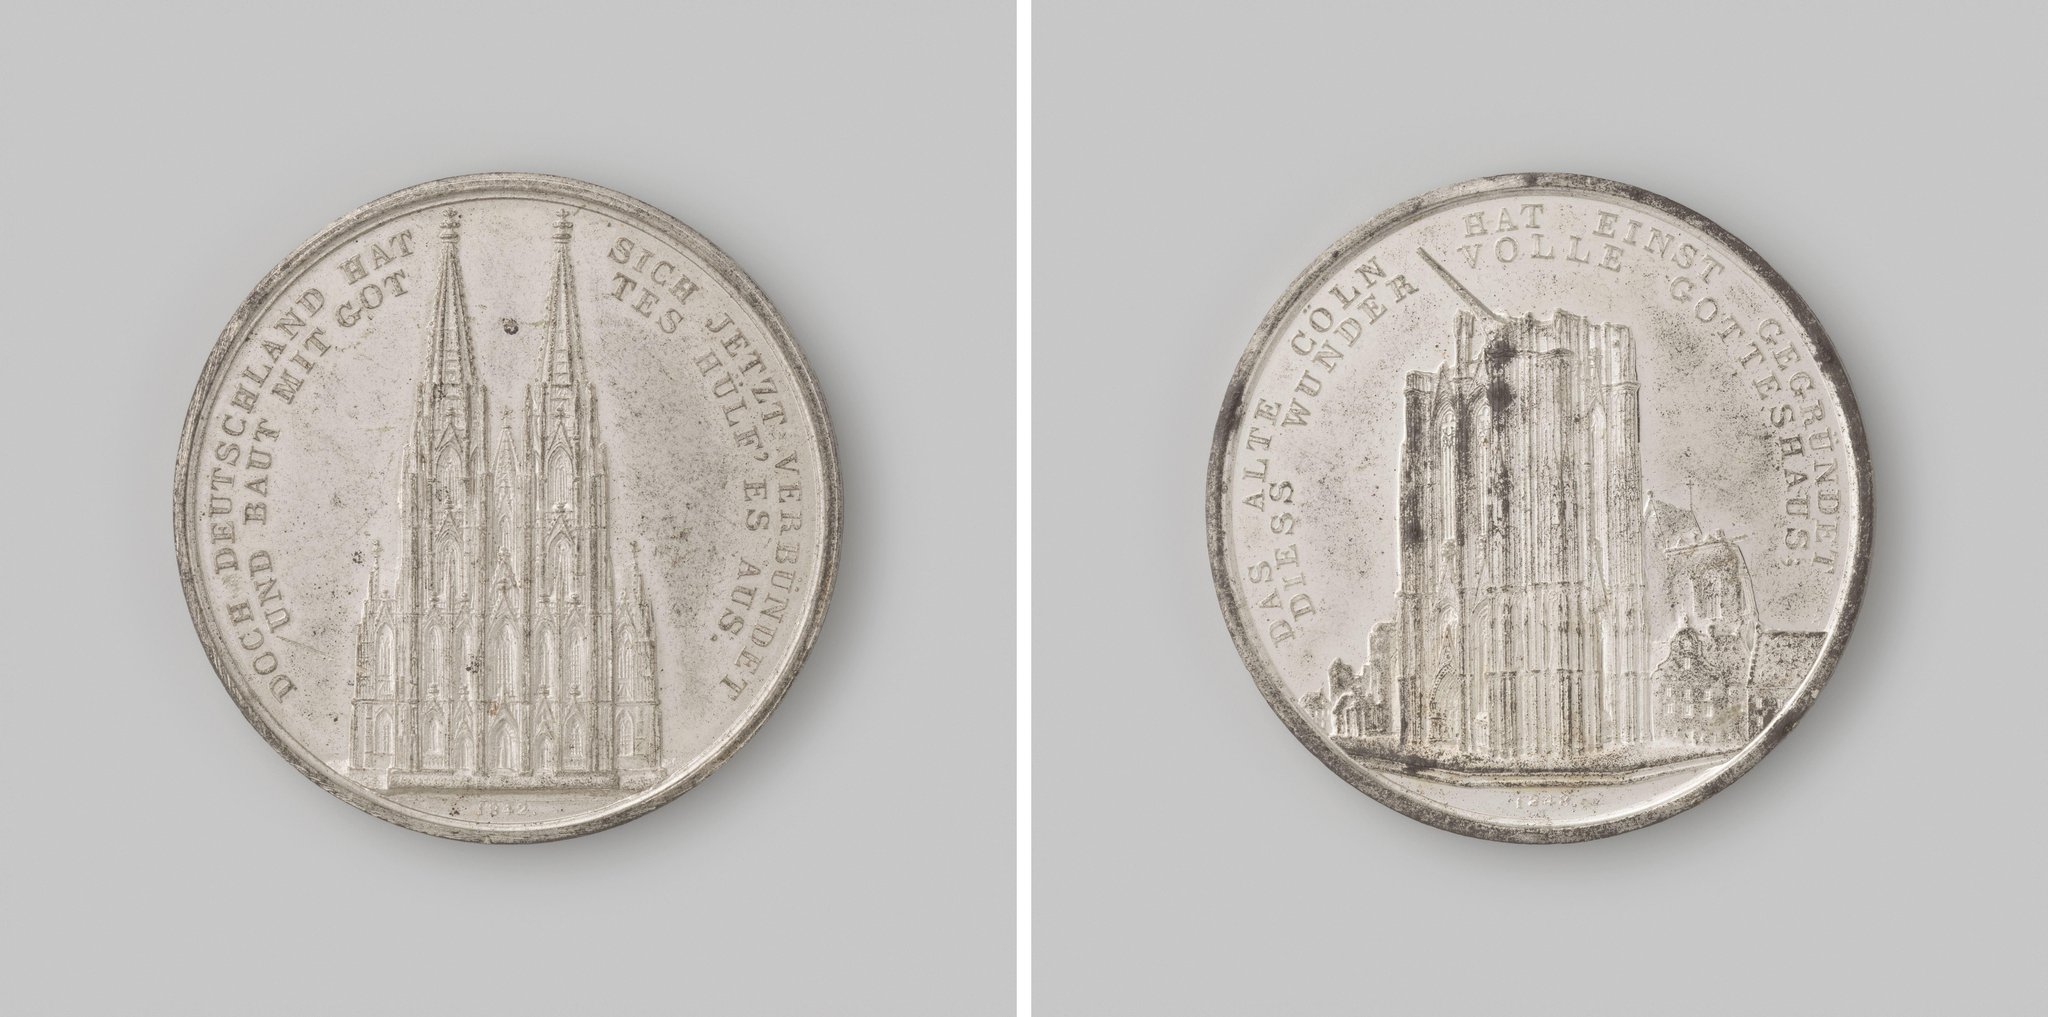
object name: history medal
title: Hervatting van de bouw van de Dom te Keulen 1842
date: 1840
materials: tin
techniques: striking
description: Tinnen penning, op de voorzijde de voltooide Dom met dubbel omschrift en afsnedetekst, op de keerzijde de Dom in aanbouw met dubbel omschrift en afsnedetekst.